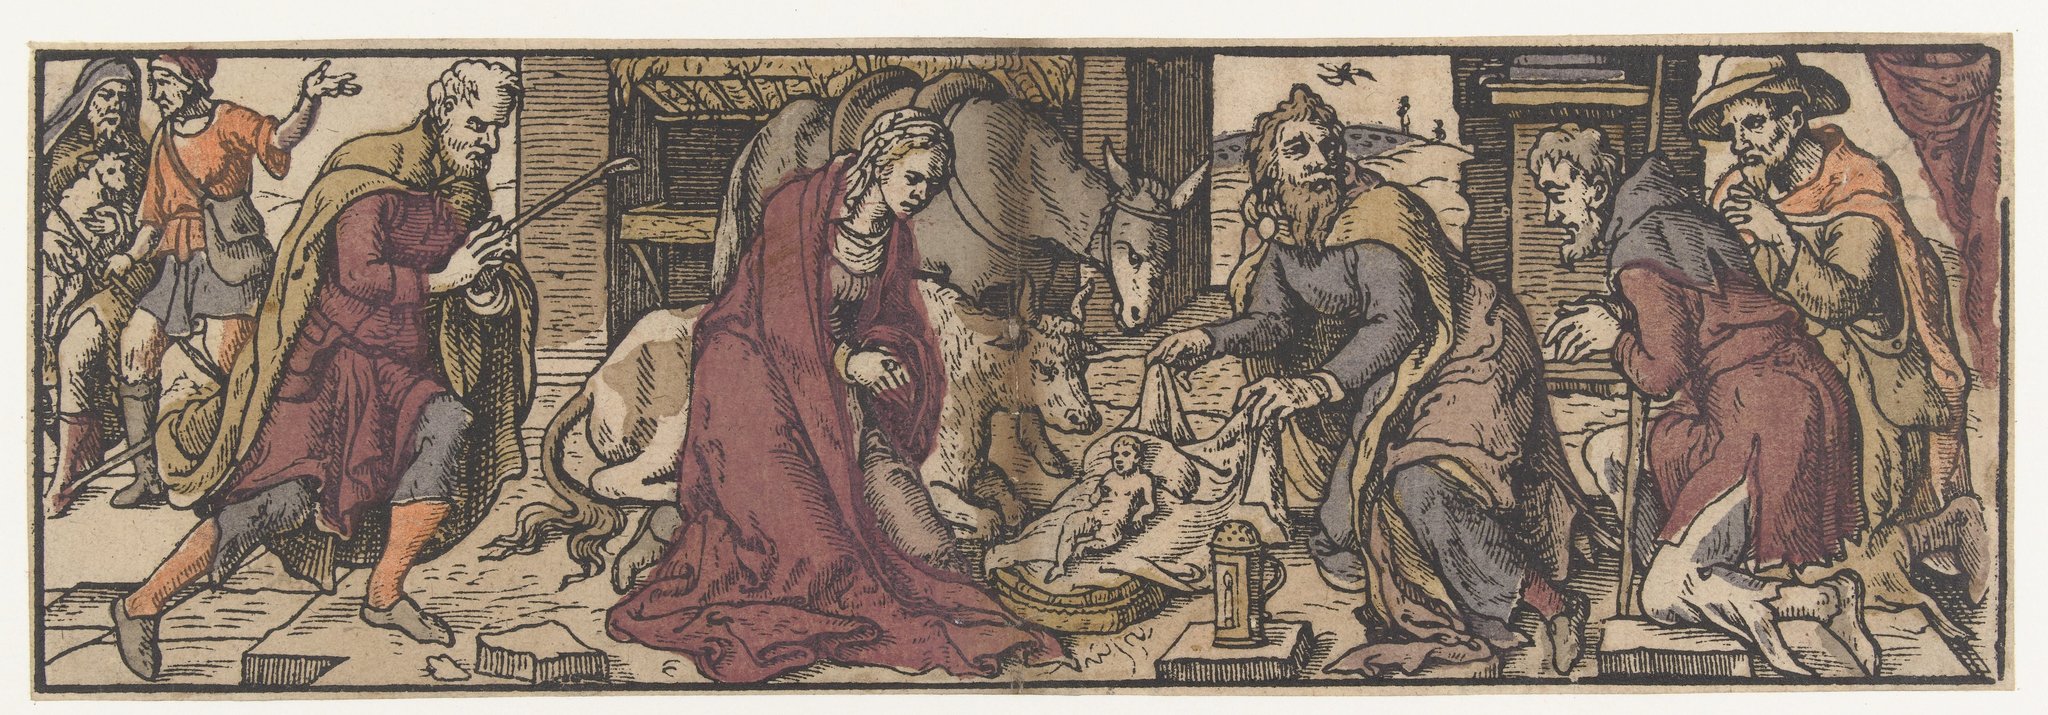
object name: print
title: Aanbidding der herders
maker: monogrammist ai (16e eeuw)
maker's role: print maker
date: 1540-1560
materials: paper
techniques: hand coloring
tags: adoration of the christ-child by the shepherds; mary and joseph present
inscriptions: stamp: Lugt 240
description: Maria, Jozef, os en ezel rond kribbe met Christuskind. Drie herders knielen, twee komen aanlopen.